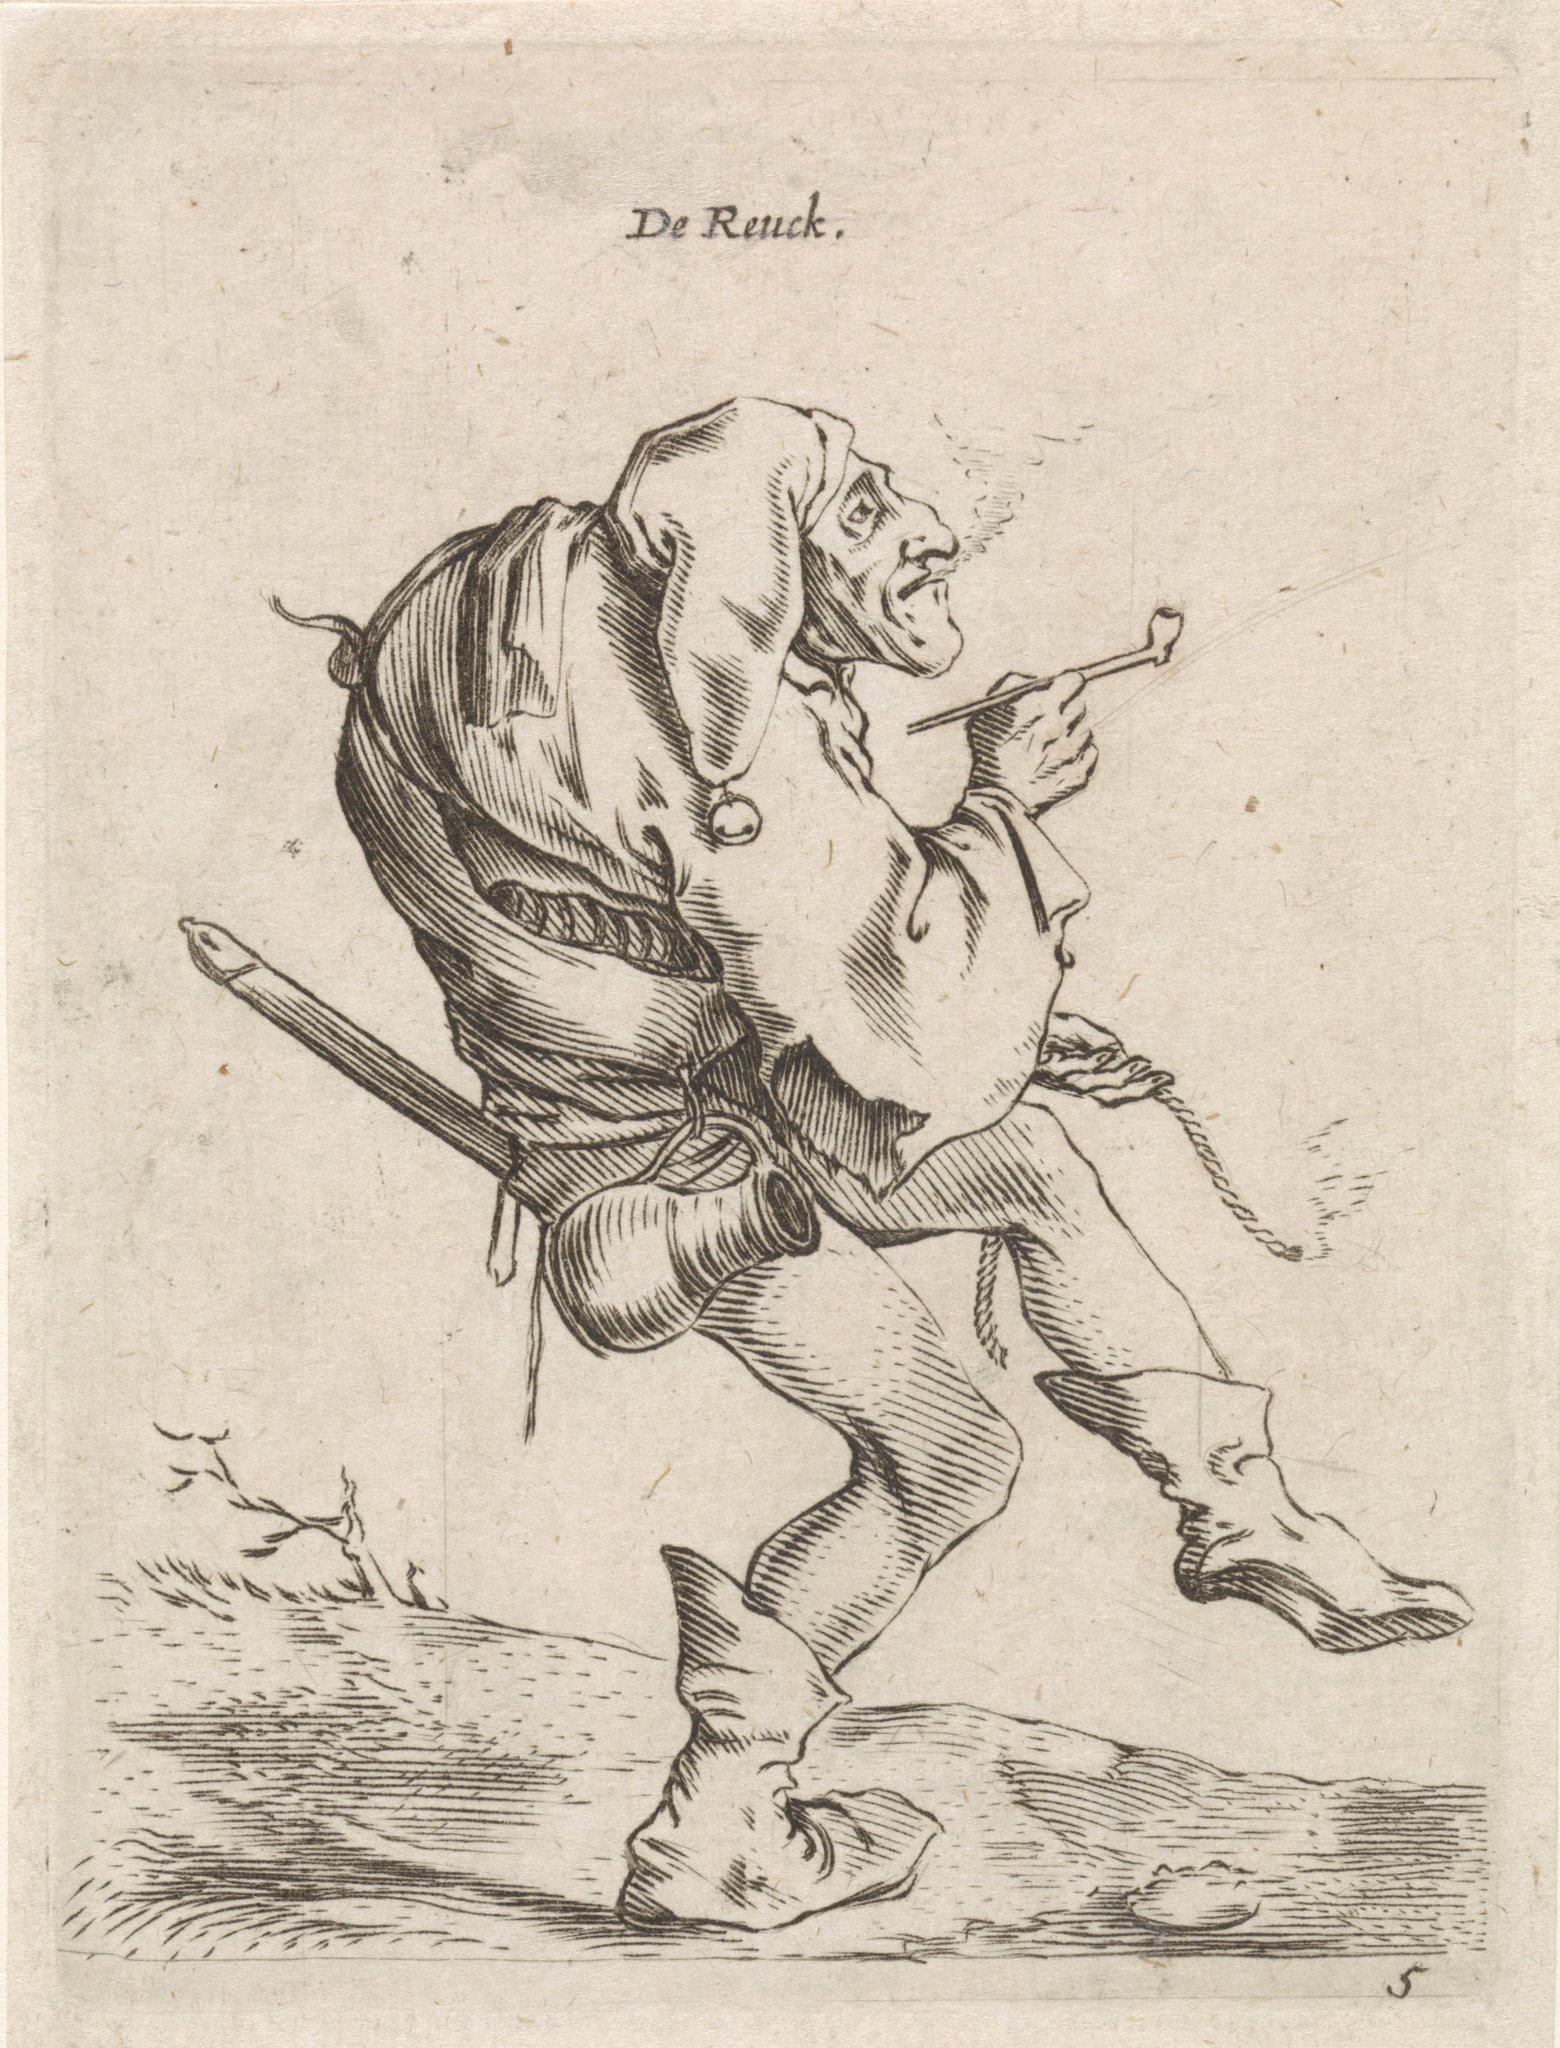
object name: print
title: De vijf zintuigen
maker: cornelis saftleven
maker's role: draughtsman, painter, print maker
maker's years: 1607-1681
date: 1645-1706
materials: paper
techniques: etching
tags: smell, smelling (one of the five senses), pipe ~ tobacco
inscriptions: collector's mark: Lugt 2228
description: De reuk. Een gebochelde man rookt een pijp. Op zijn hoofd een lange muts met een bel. De prent maakt deel uit van een serie met de vijf zintuigen.